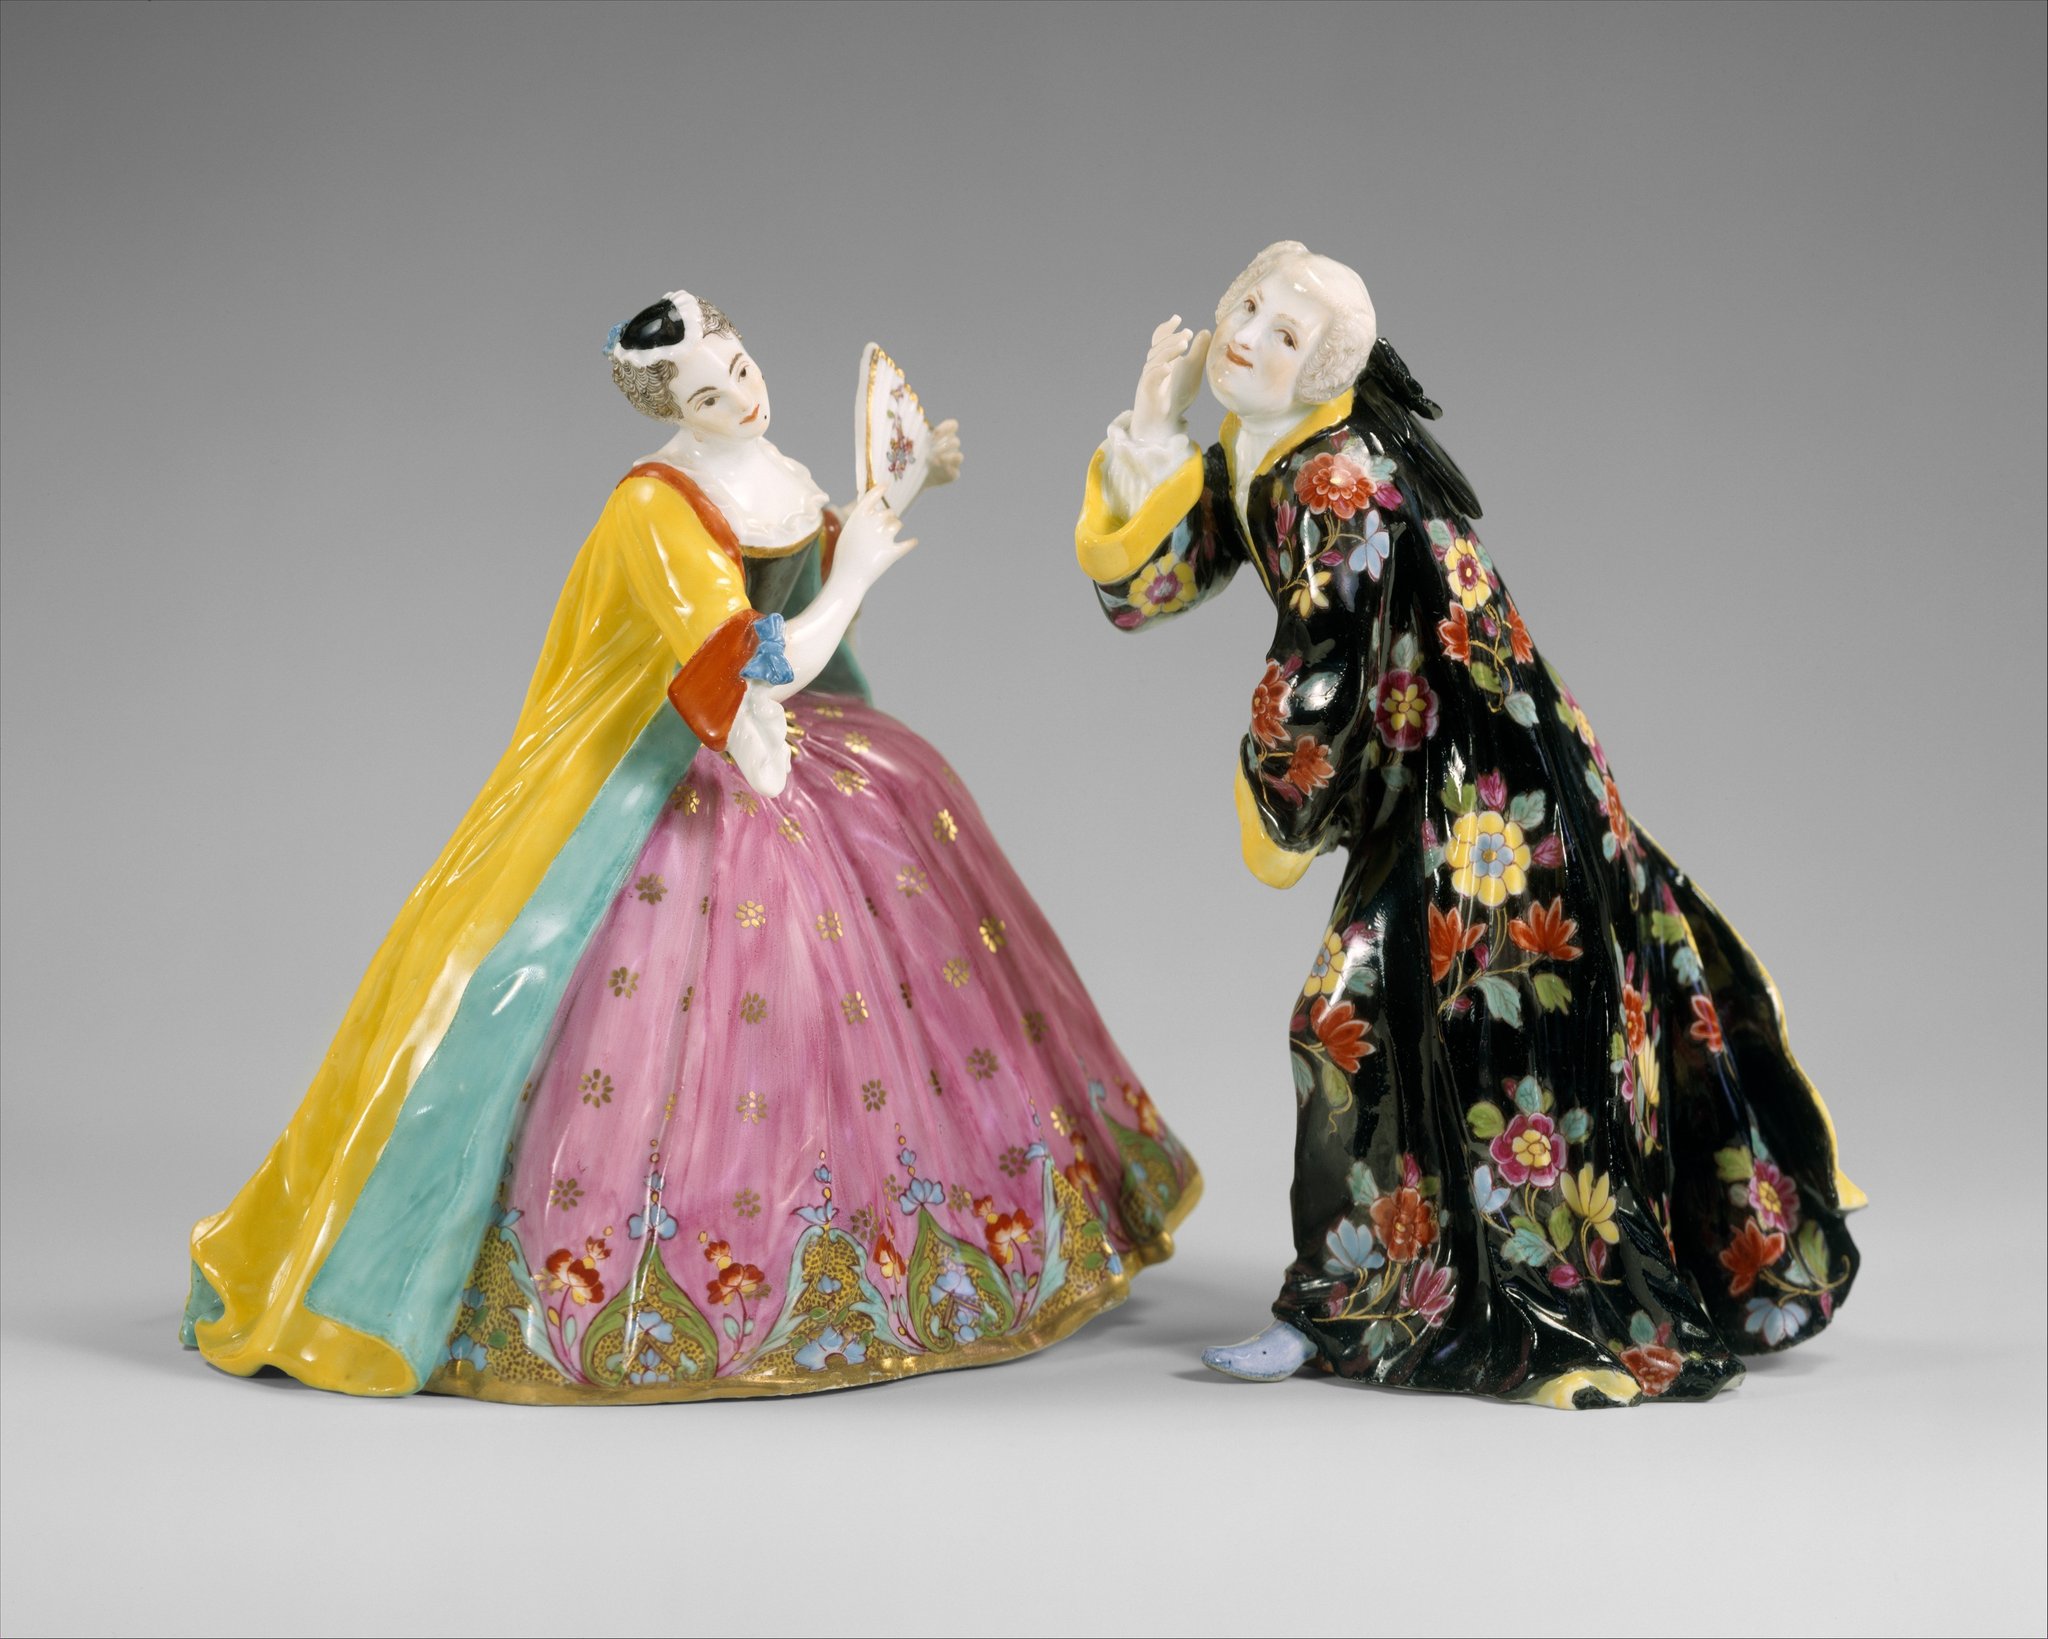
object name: figure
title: The Thrown Kiss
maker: meissen manufactory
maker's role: manufactory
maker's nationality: german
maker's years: 1710-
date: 1736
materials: hard paste porcelain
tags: men,women,flowers,leaves